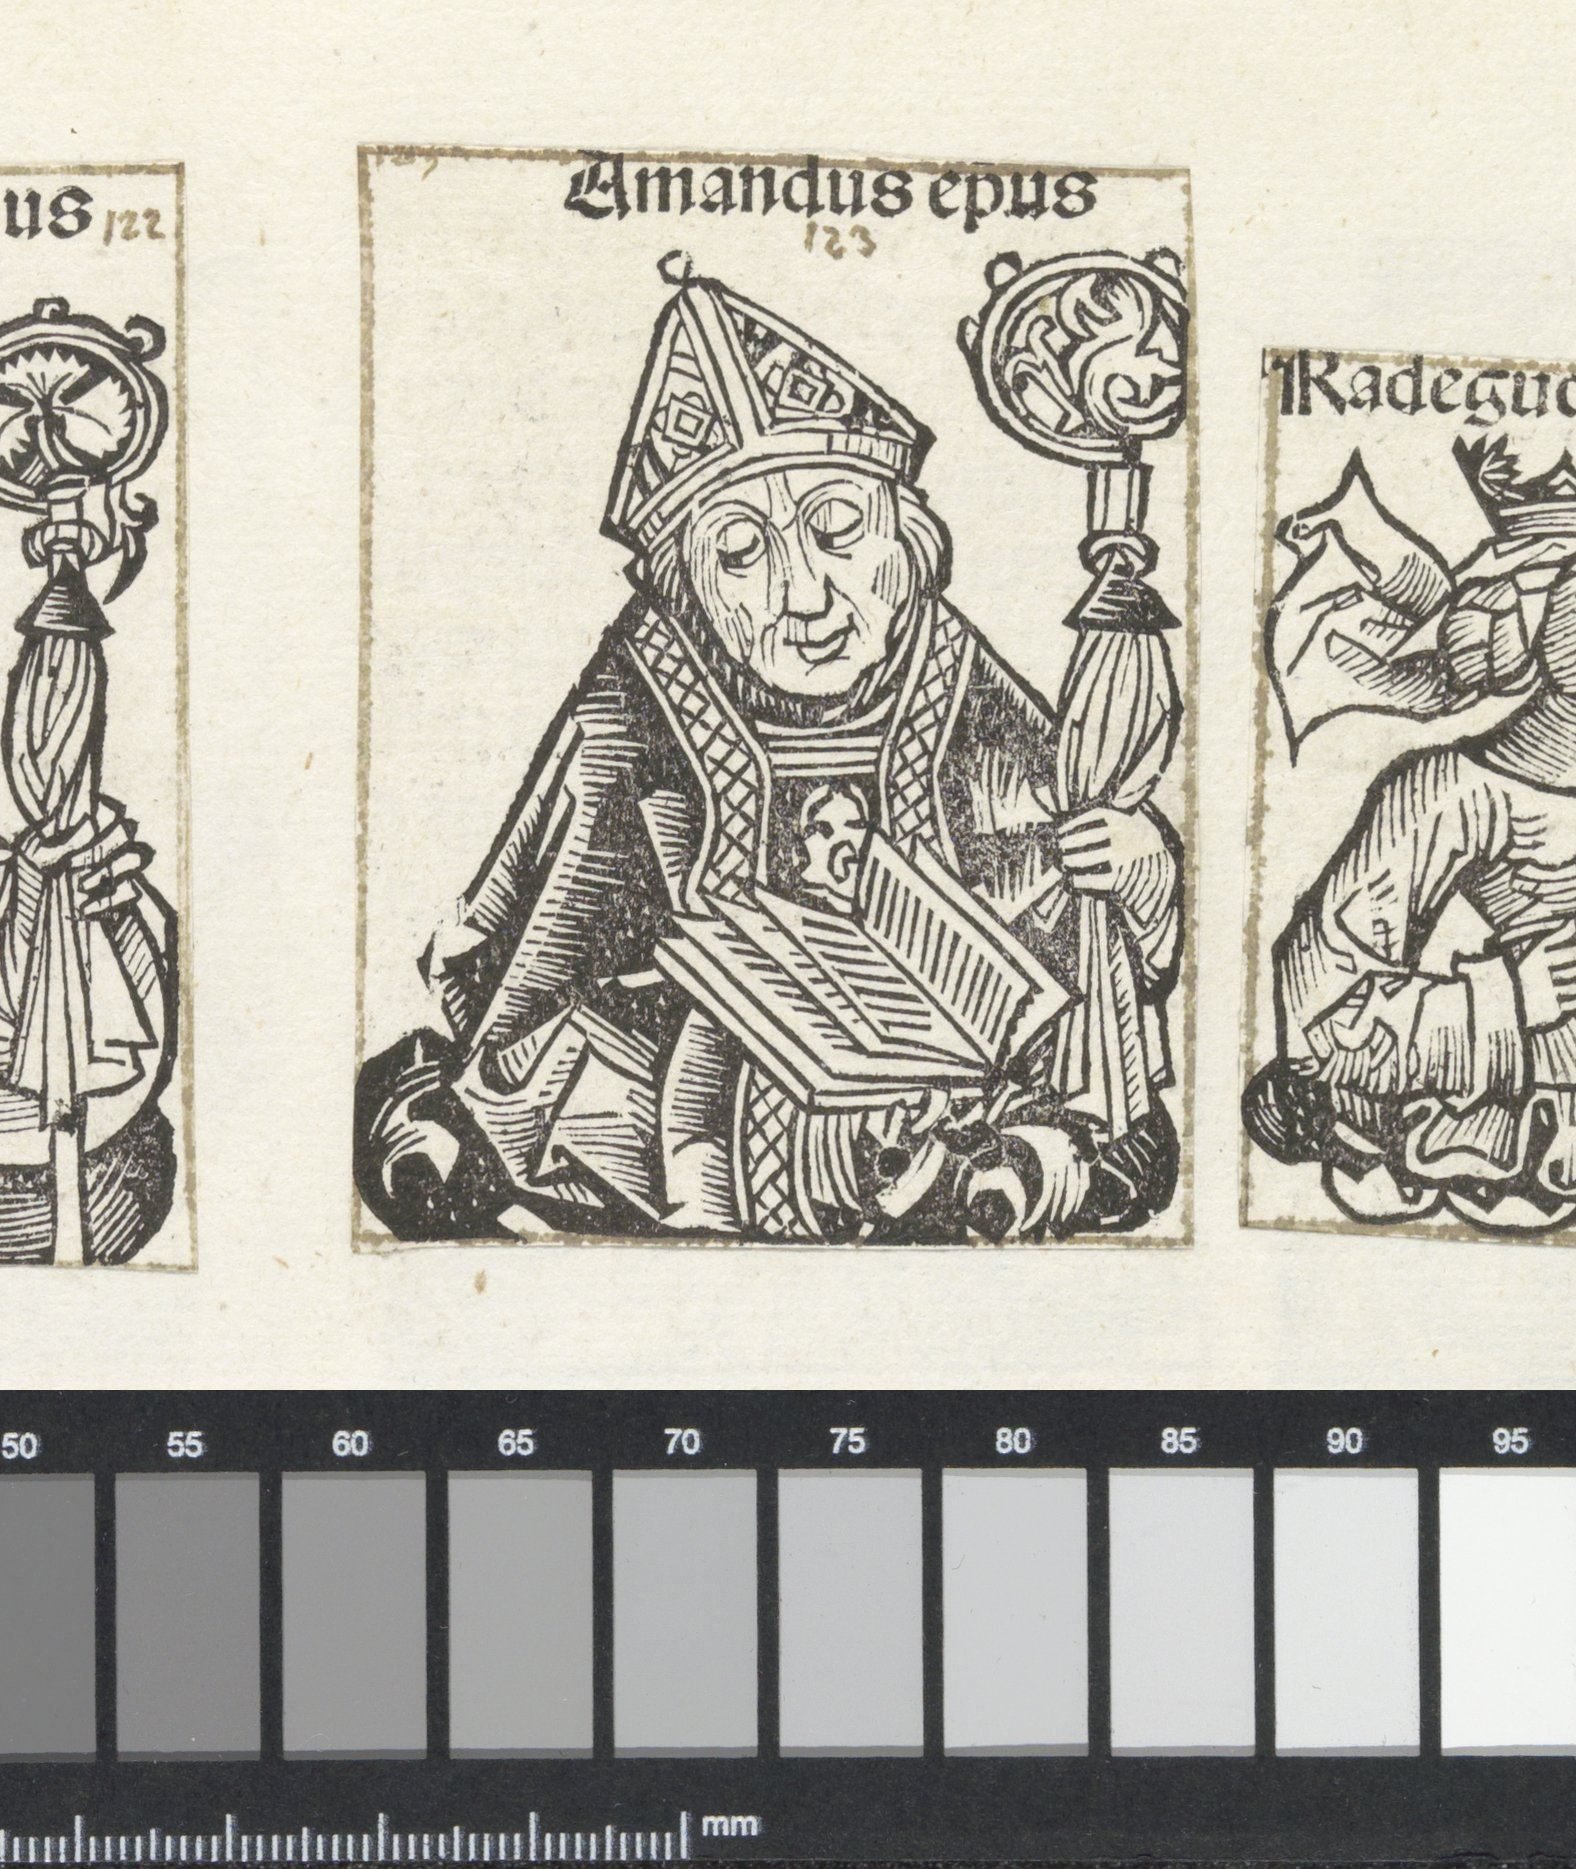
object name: album leaf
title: Heilige Amandus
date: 1493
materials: paper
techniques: letterpress printing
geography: nuremberg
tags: archbishop, bishop, etc. (roman catholic), amand(us) of maastricht; possible attributes: snake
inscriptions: inscription: ‘123’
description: De houtsnede wordt herhaaldelijk gebruikt als boekillustratie in de Liber Chronicarum (of Neurenbergkroniek) van Hartmann Schedel, verschenen in het Latijn en Duits in 1493. Zie de Latijnse uitgave, folio 148r.